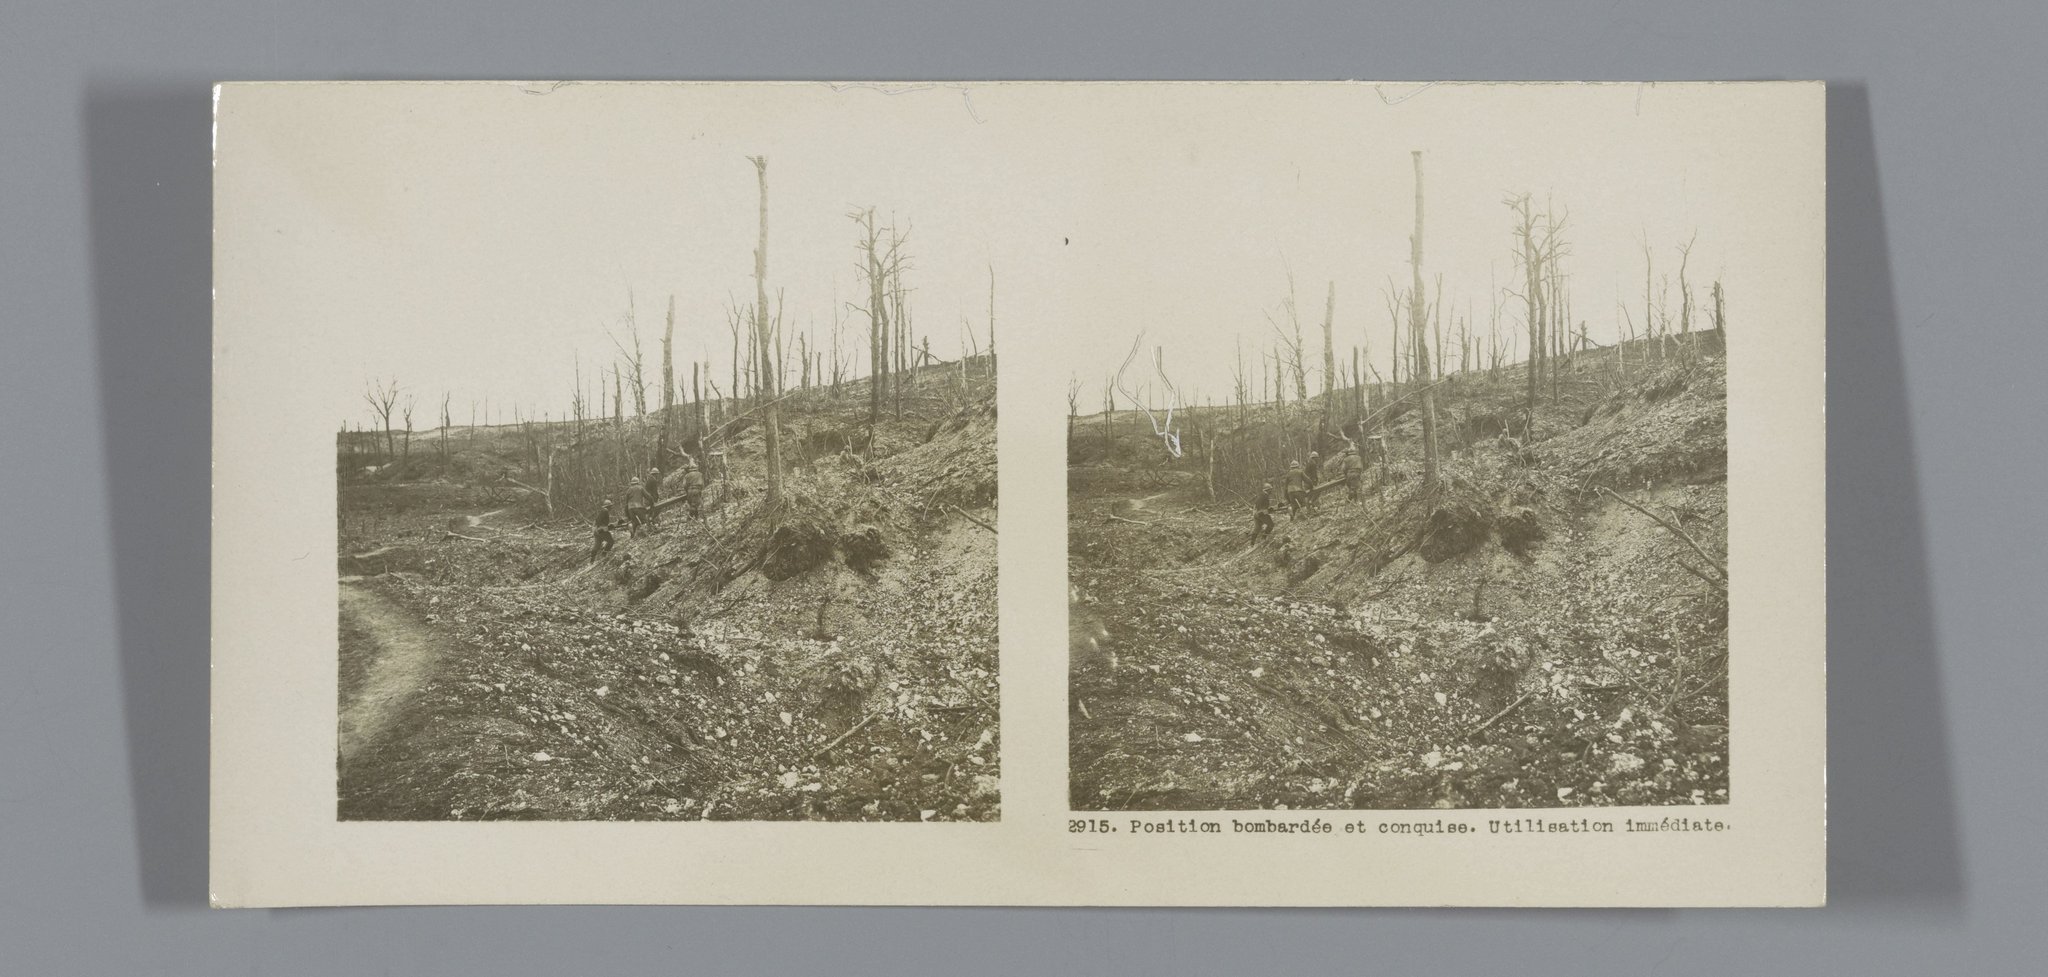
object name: stereograph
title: Franse soldaten op een op de Duitse troepen veroverde helling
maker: Anonymous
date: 1914-1918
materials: cardboard, photographic support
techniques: gelatin silver print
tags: low hill country, private soldier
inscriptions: number: ‘2915.’